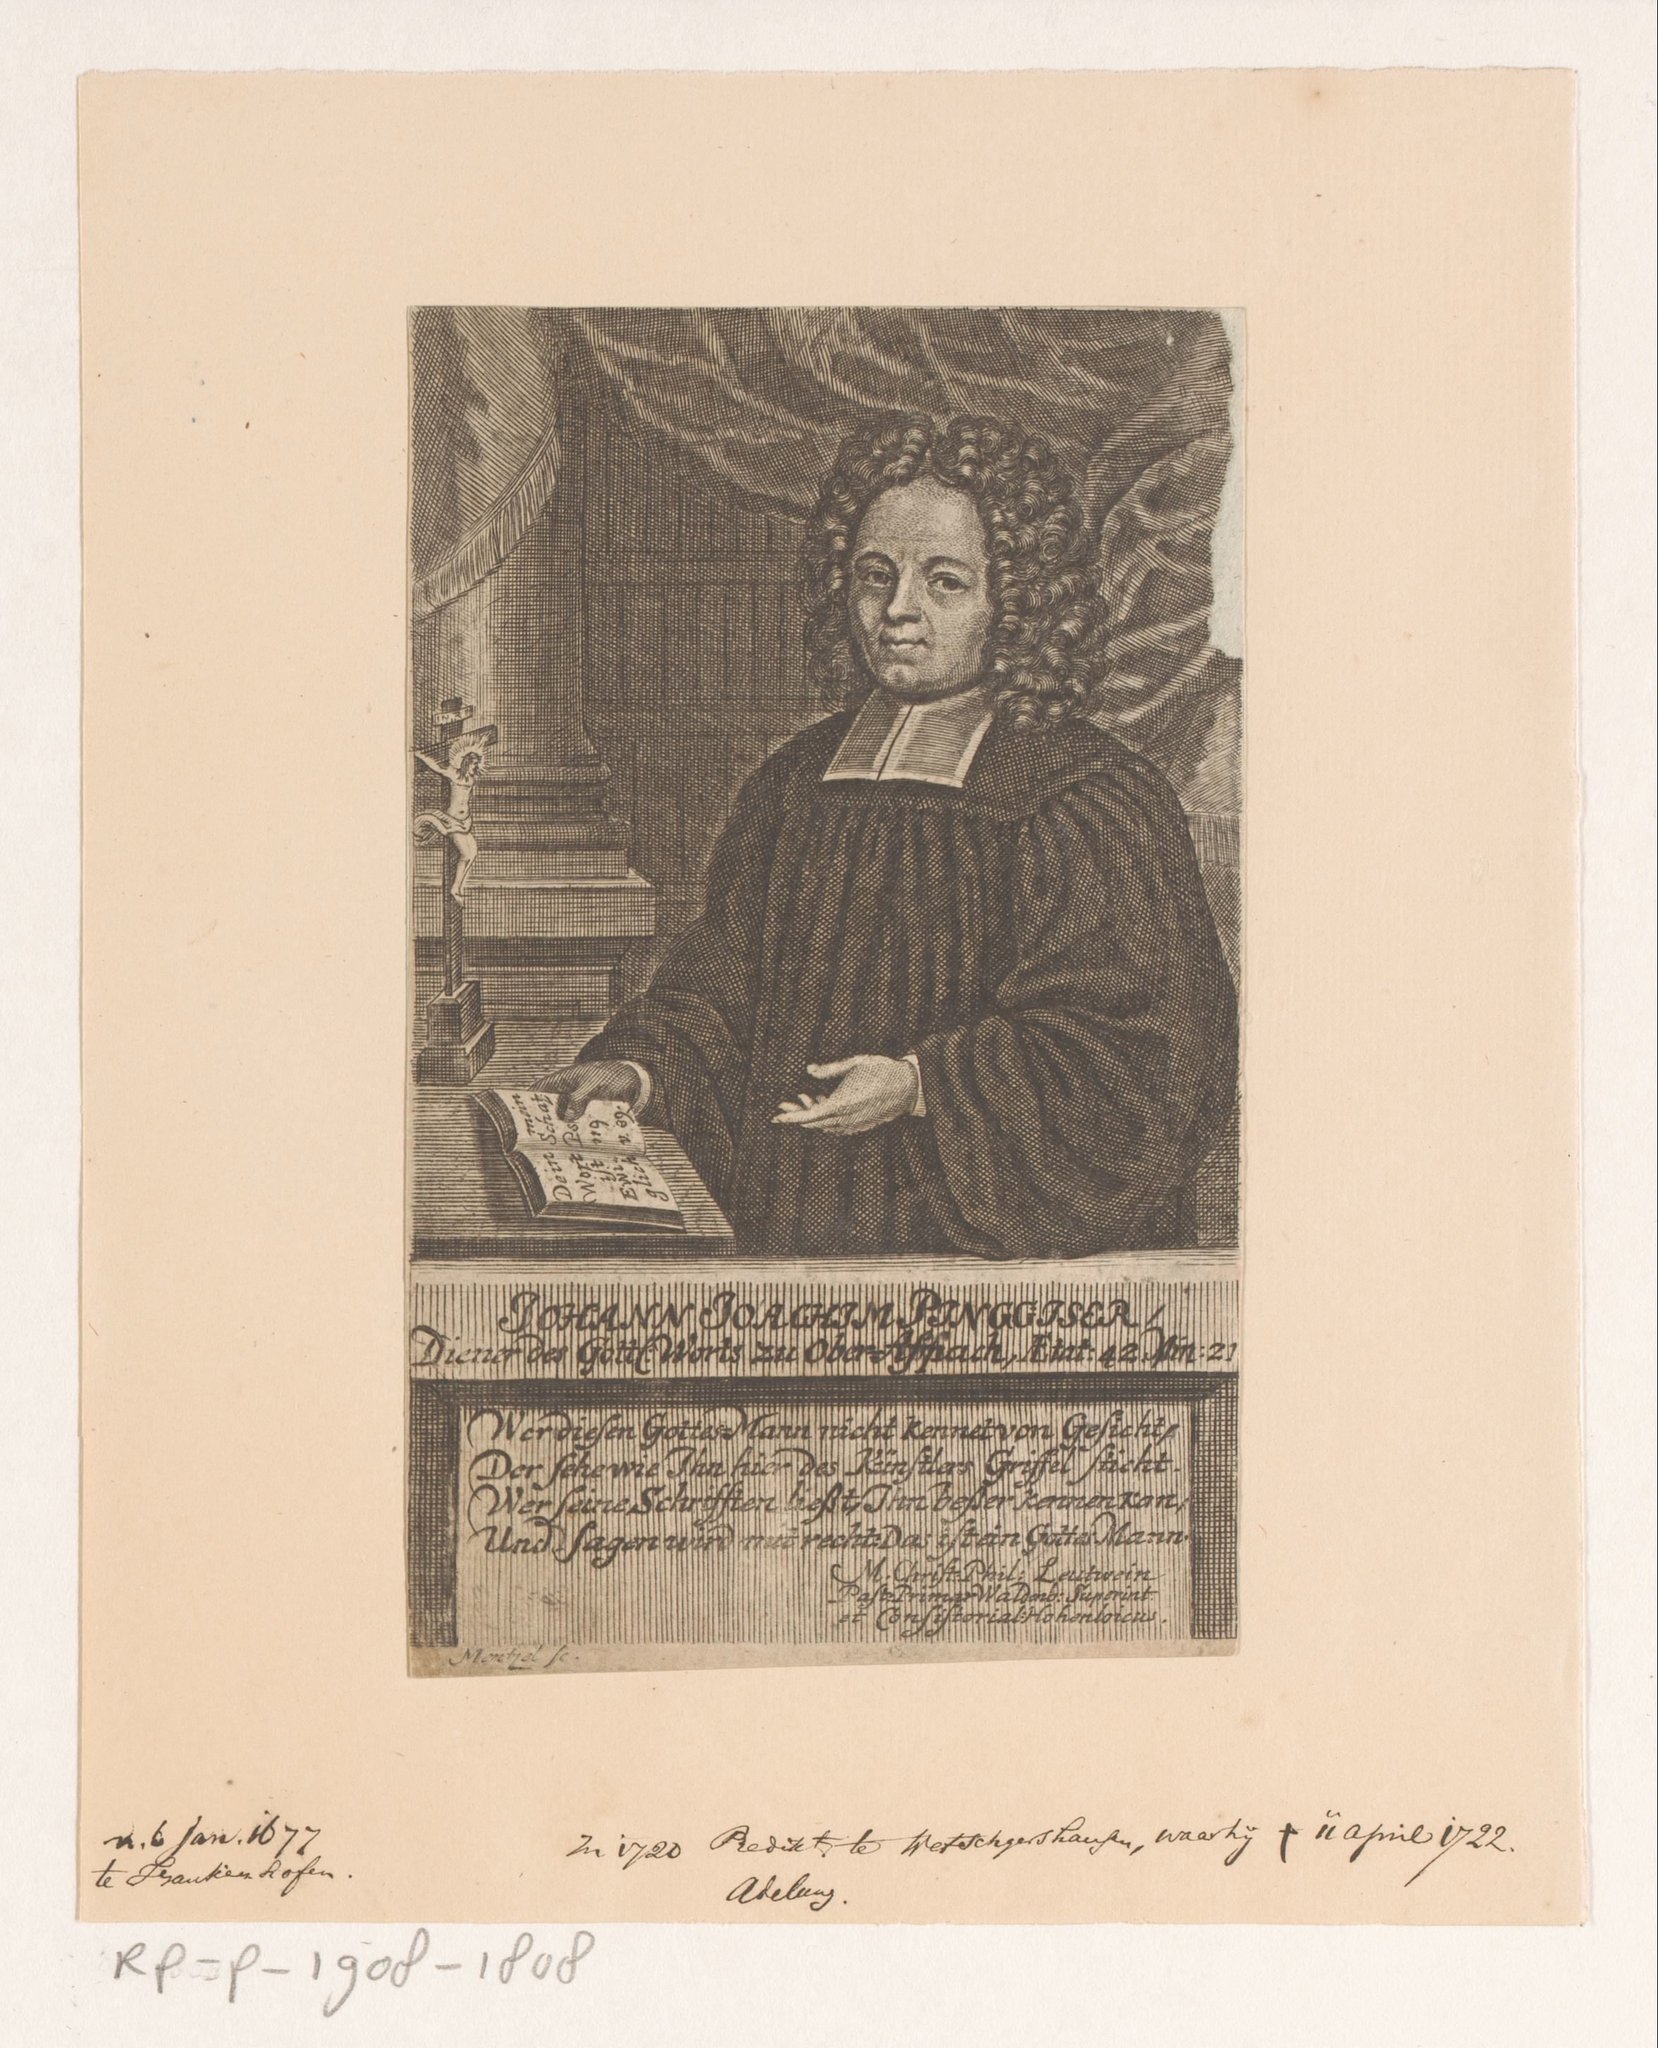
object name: print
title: Portret van Johann Joachim Pinggieser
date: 1687-1743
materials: paper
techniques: engraving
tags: theologian, historical persons, wig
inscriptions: collector's mark: Lugt 2228